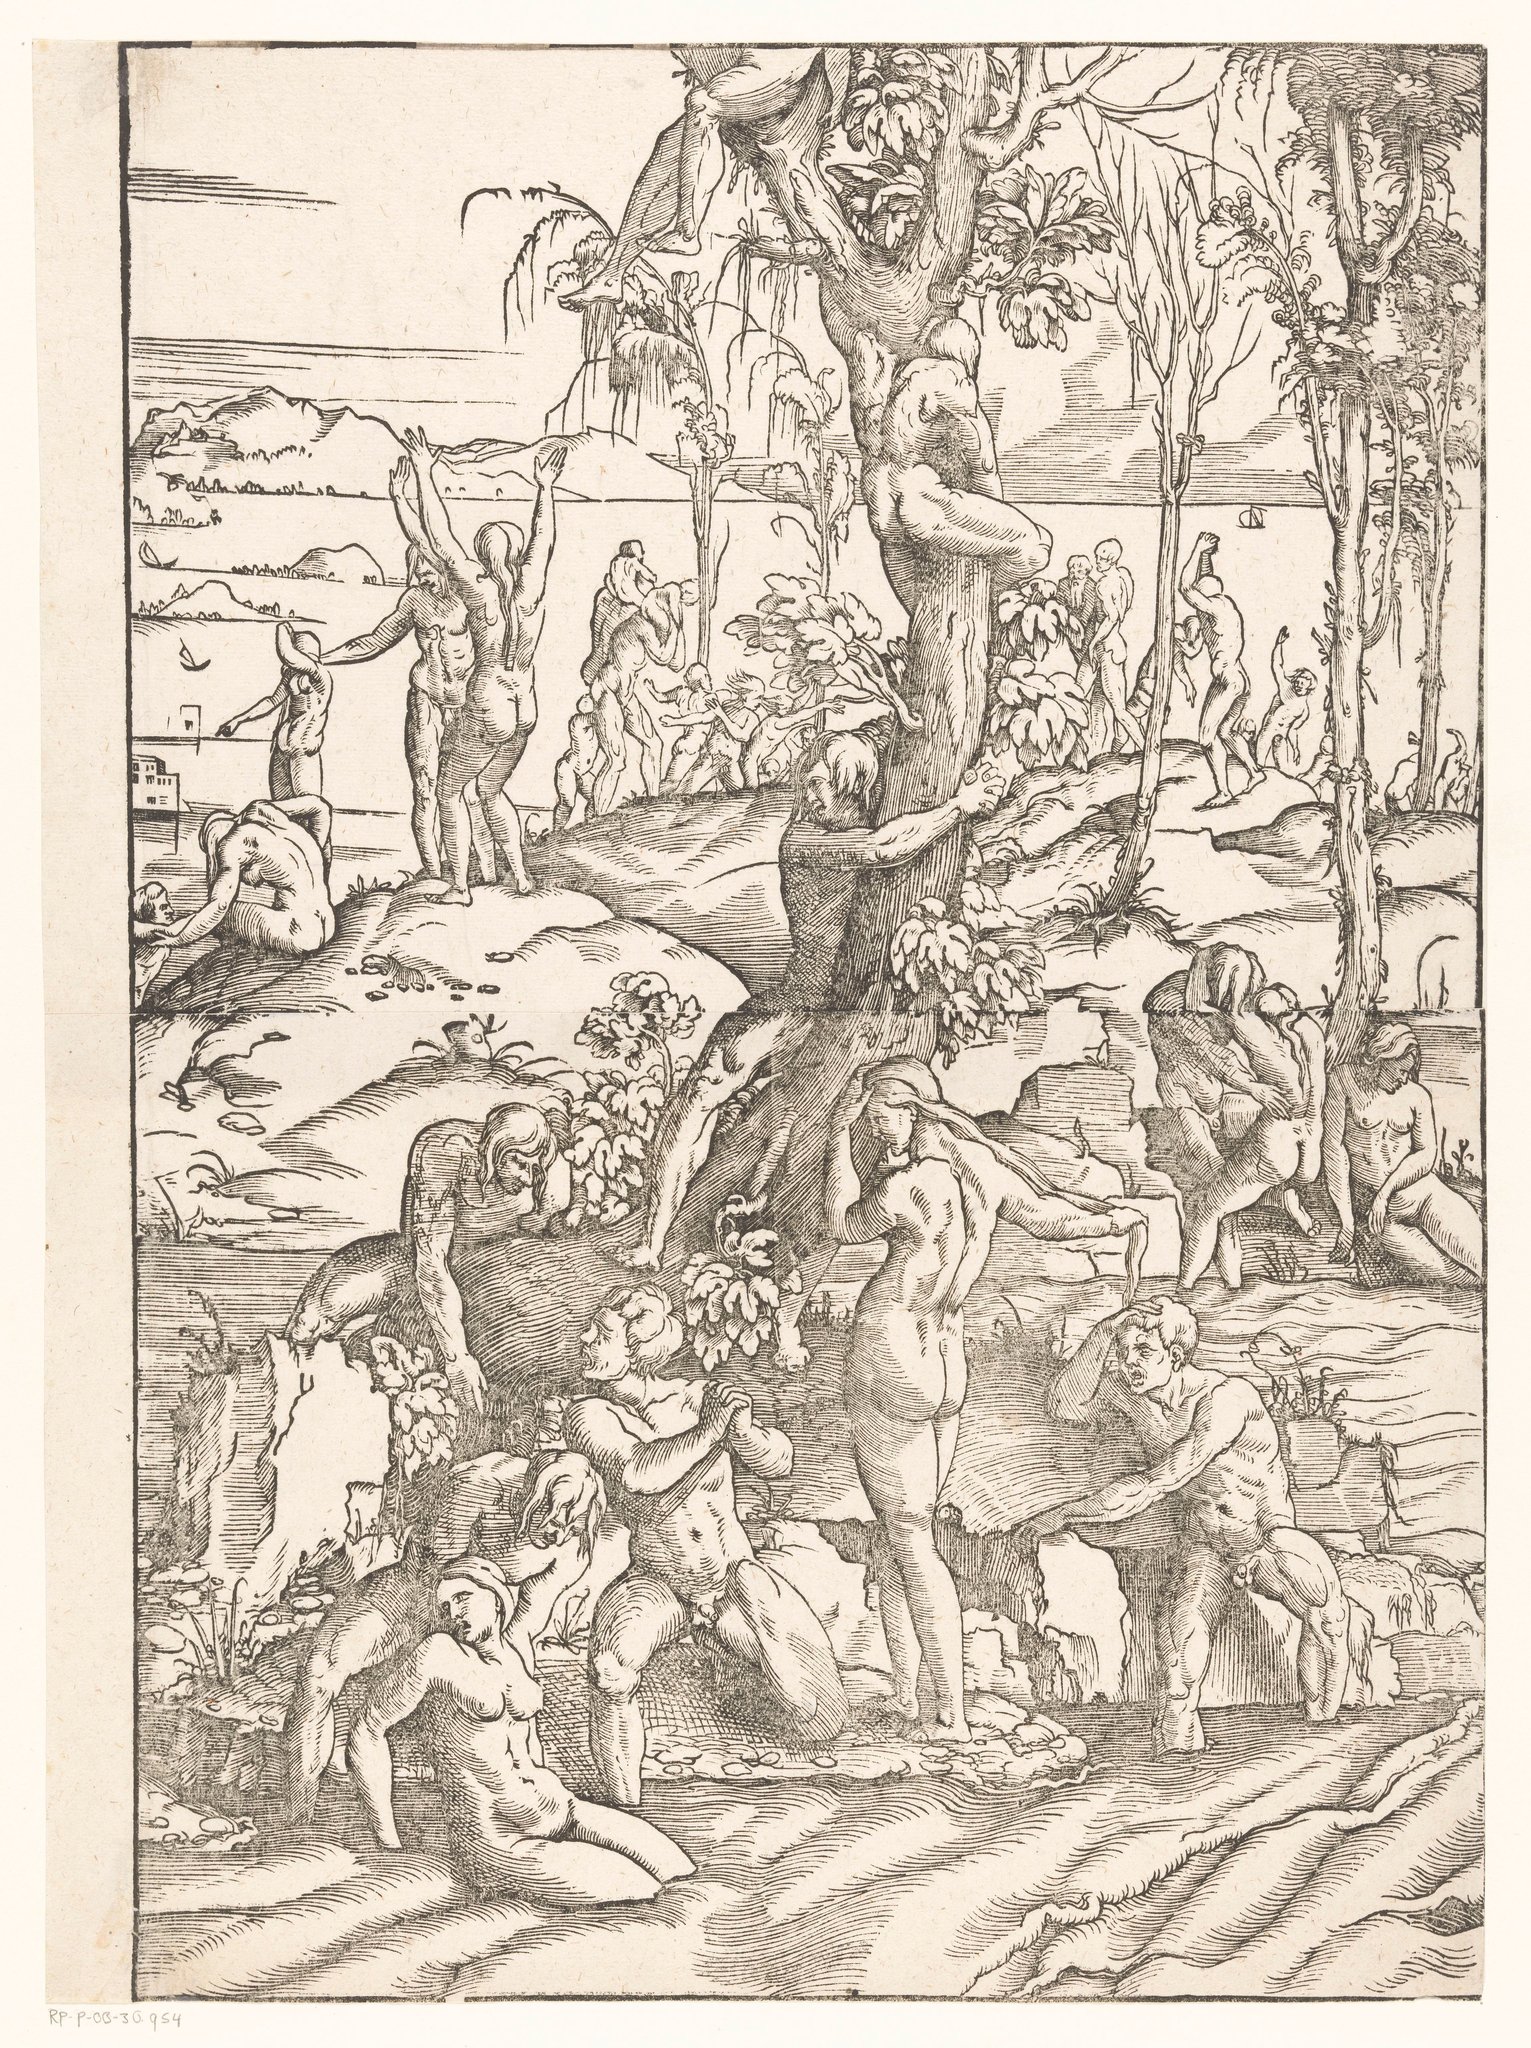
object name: print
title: Zondvloed (rechterhelft)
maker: nicolò boldrini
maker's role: painter, print maker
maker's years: 1500-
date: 1540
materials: paper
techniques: woodcut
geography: venice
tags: the flood and destruction of mankind ~ story of noah (genesis 7:10 - 8:17)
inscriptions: collector's mark: Lugt 2228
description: Mannen en vrouwen proberen zichzelf en anderen in veiligheid te brengen tijdens de Zondvloed. Links een tempel en op het water de ark van Noach.